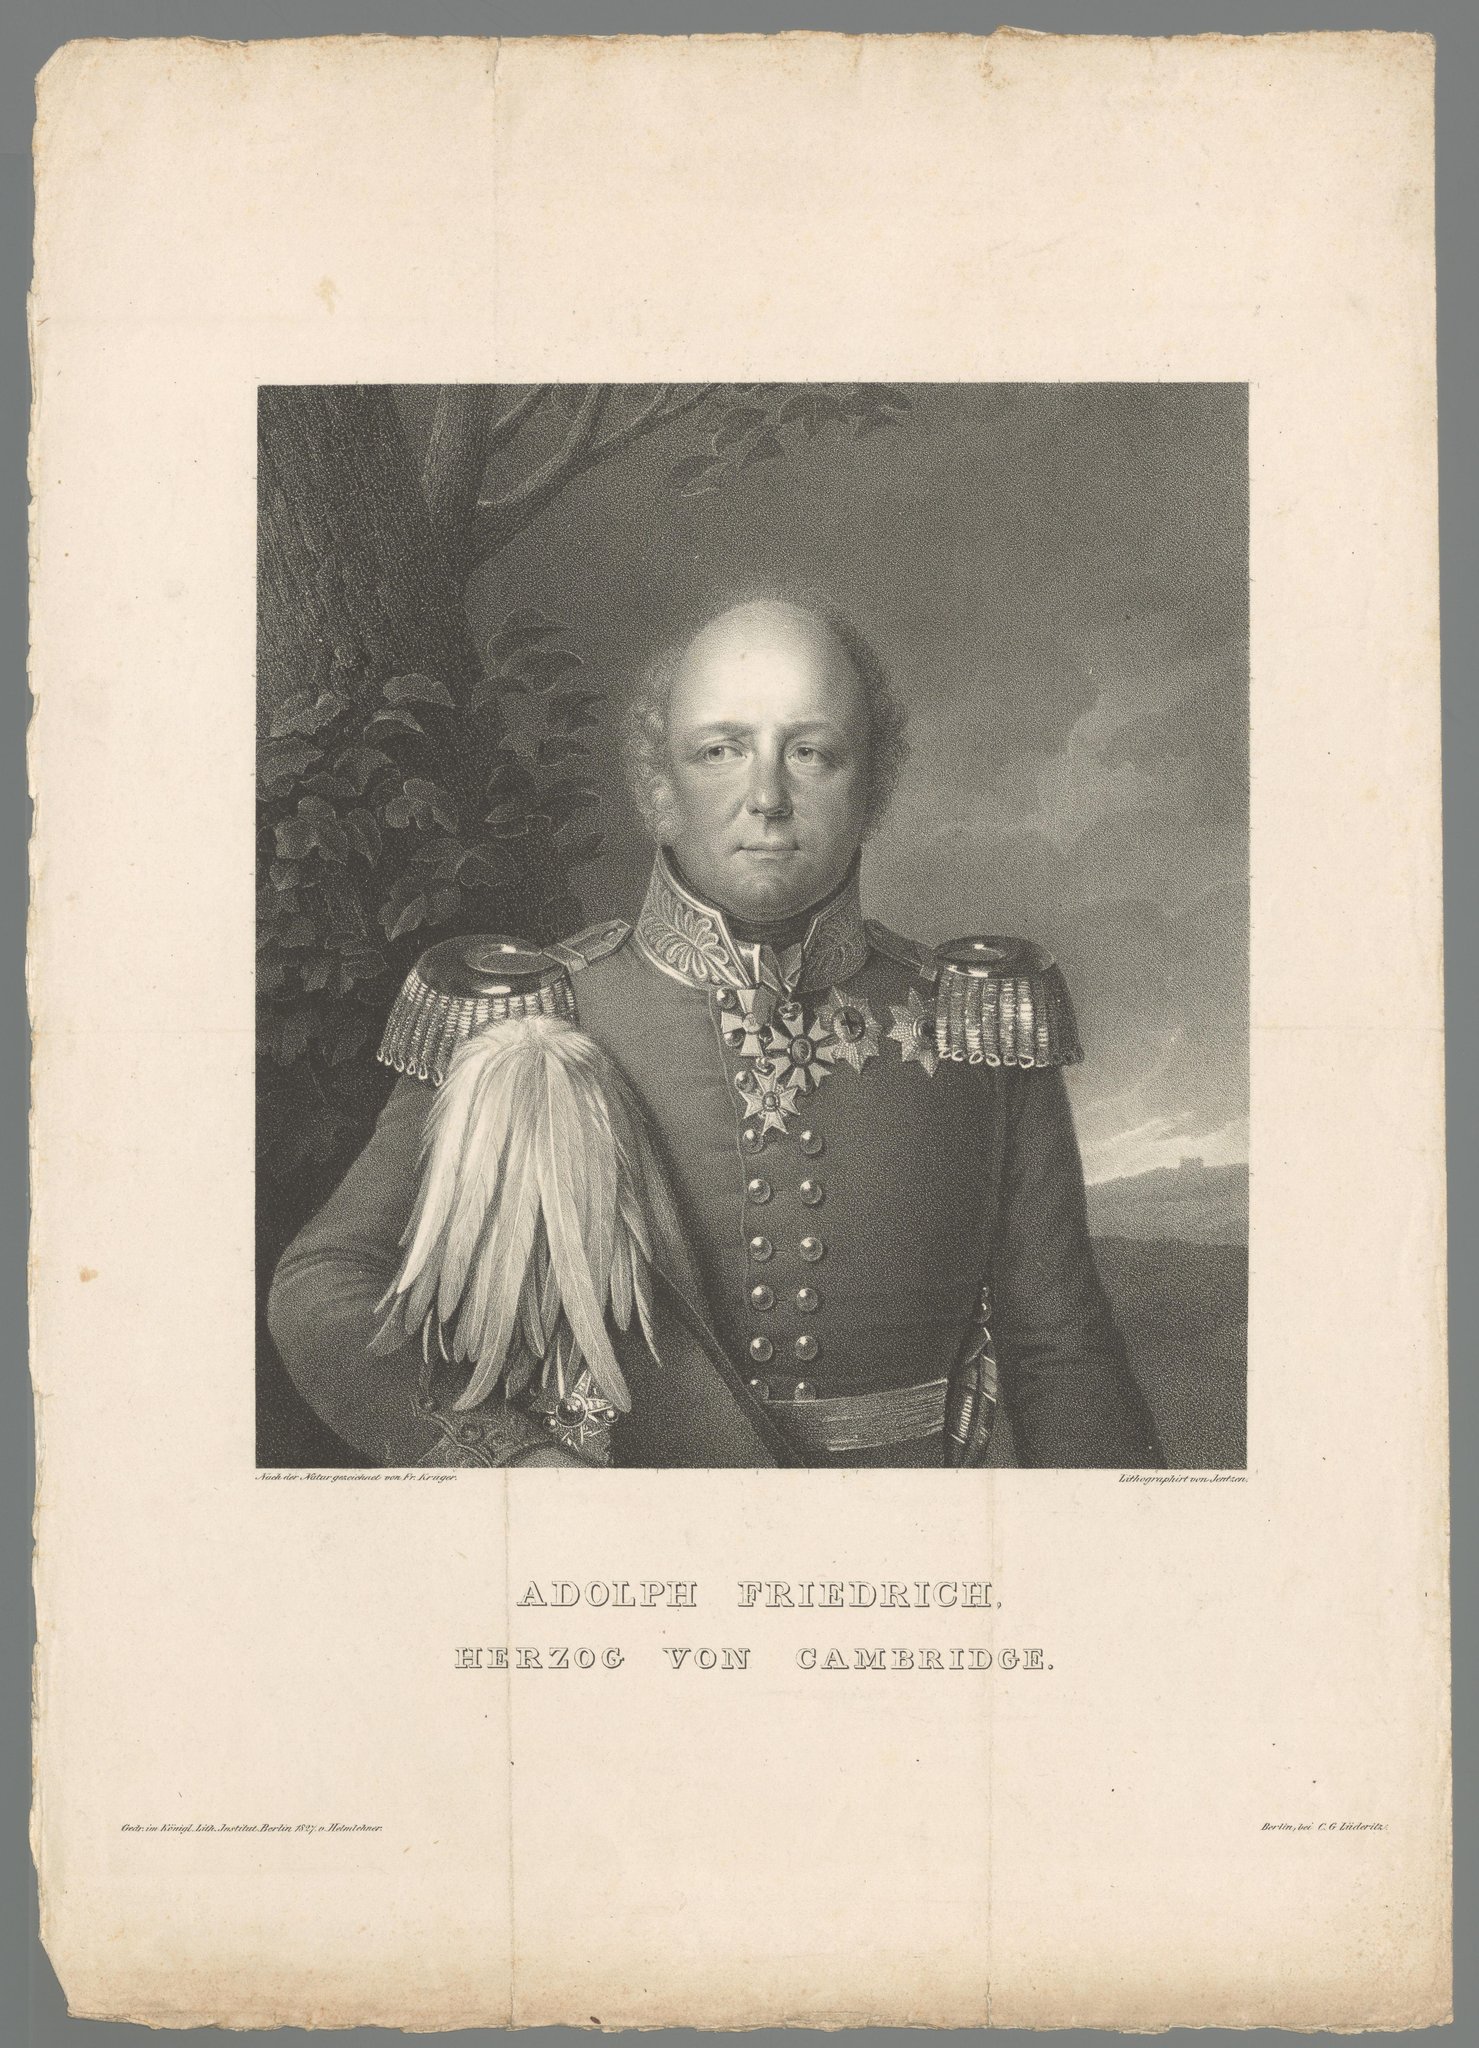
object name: print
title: Adolph Friedrich, Herzog von Cambridge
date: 1827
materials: paper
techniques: lithograph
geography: berlin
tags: adult man, historical persons, (military) uniforms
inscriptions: collector's mark: Lugt 2228